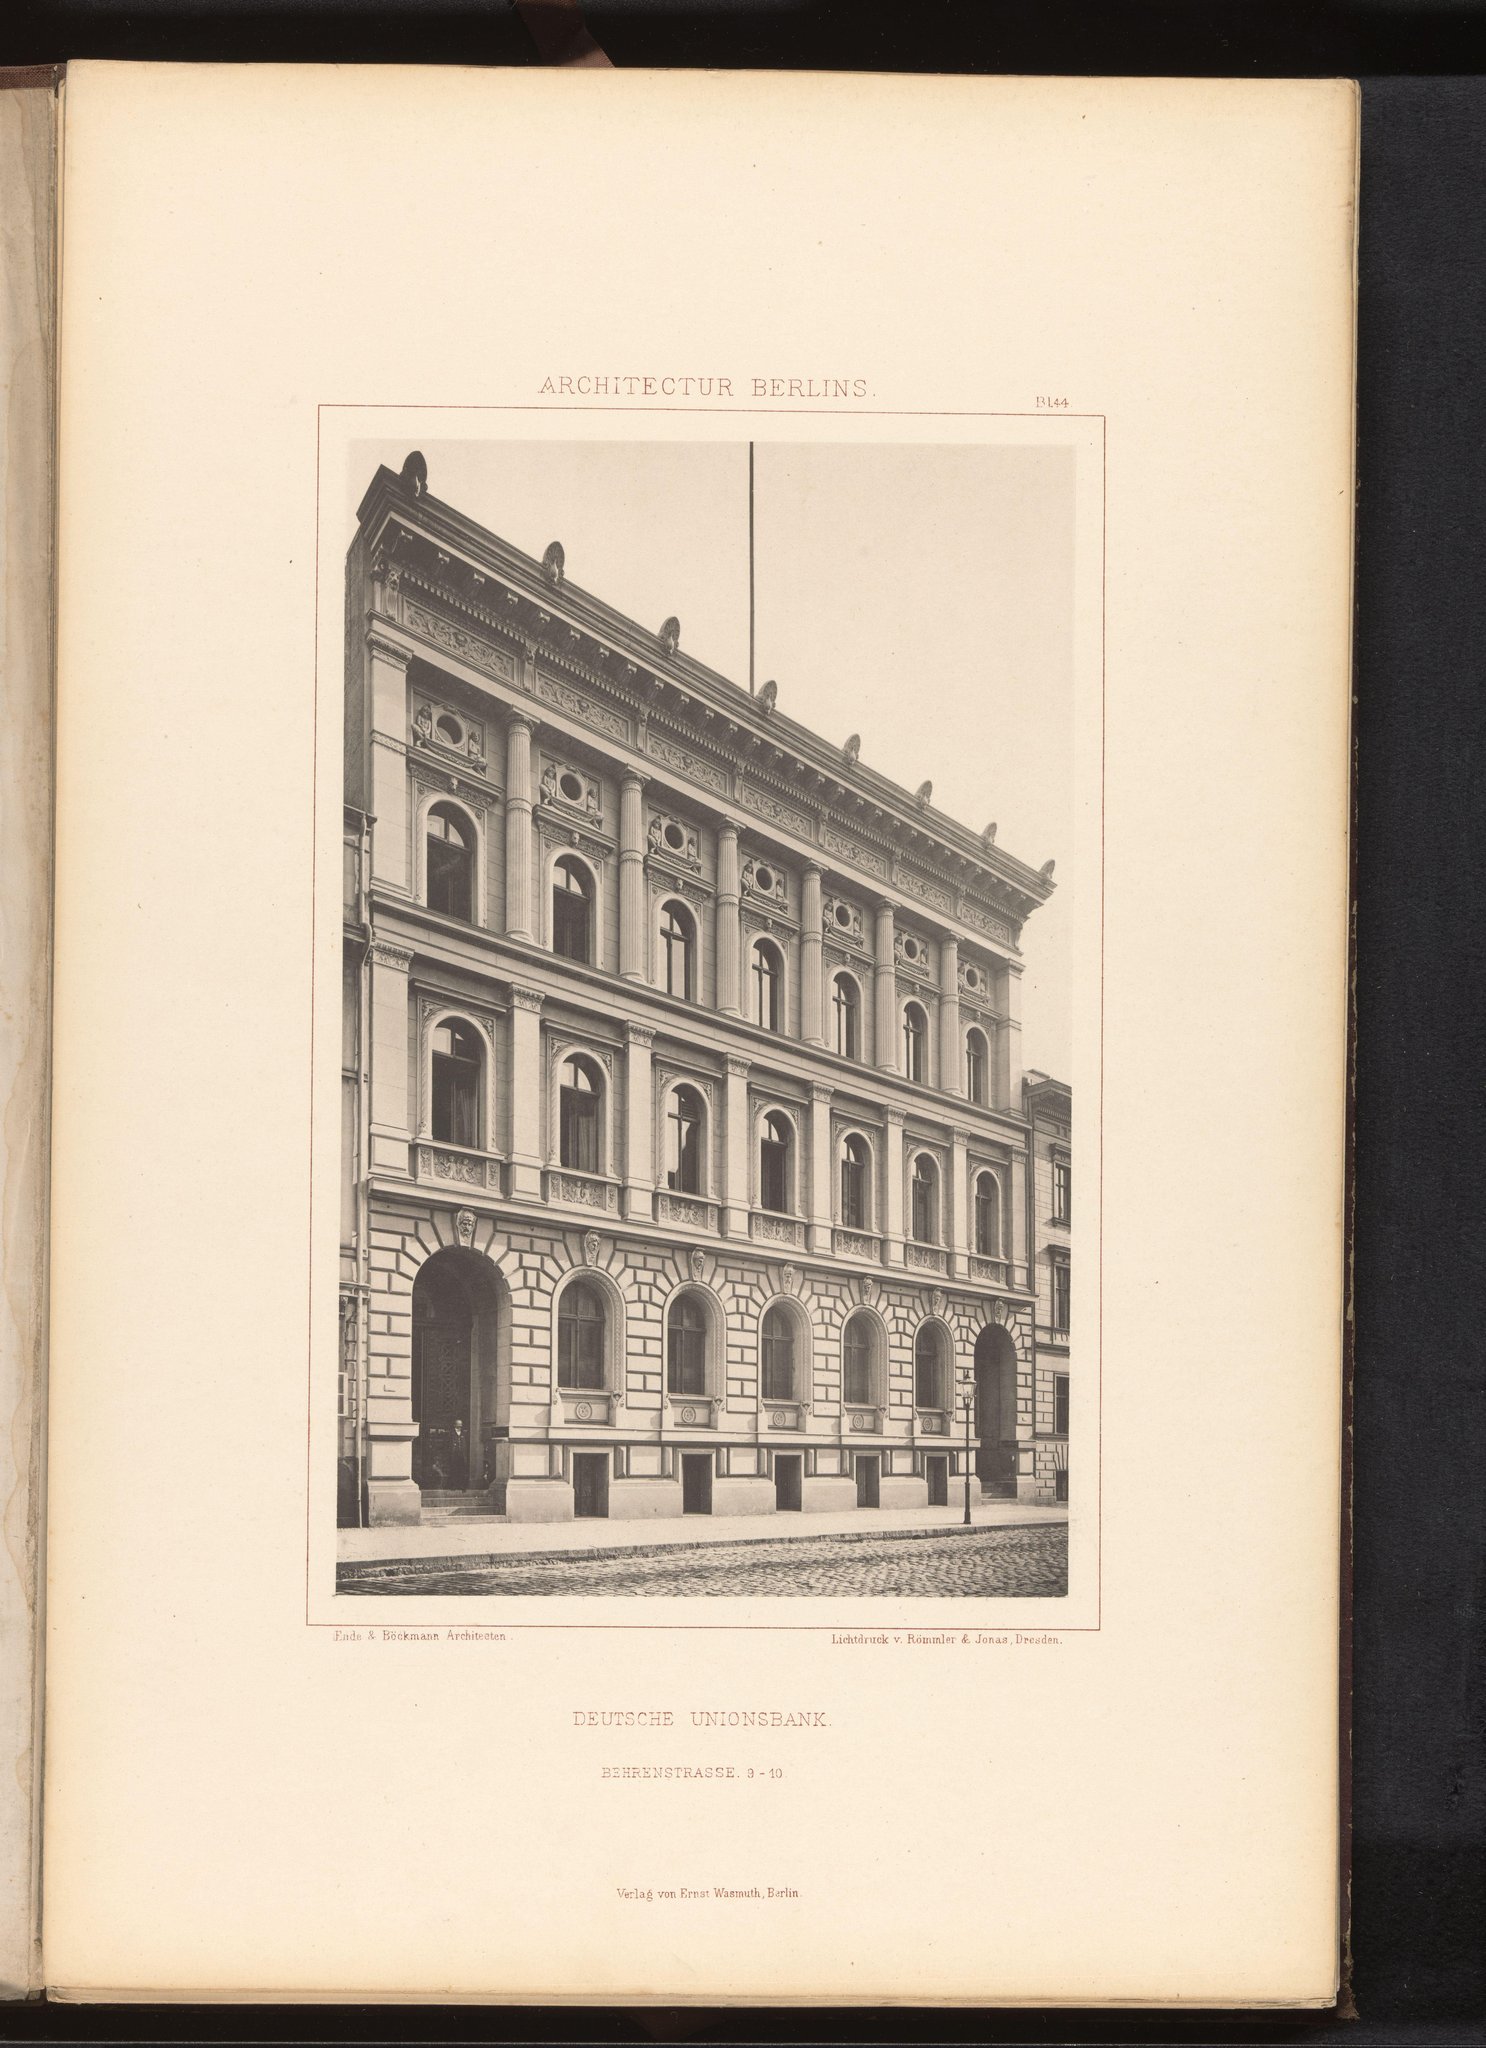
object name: photomechanical print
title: Architectur Berlins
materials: paper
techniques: photograph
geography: berlin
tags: bank, berlin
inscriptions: number: ‘Bl. 44.’, inscription: ‘Ende & Böckmann, Architecten.’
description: Deze prent maakt deel uit van een omslag met honderd prenten en zes tekstbladen.